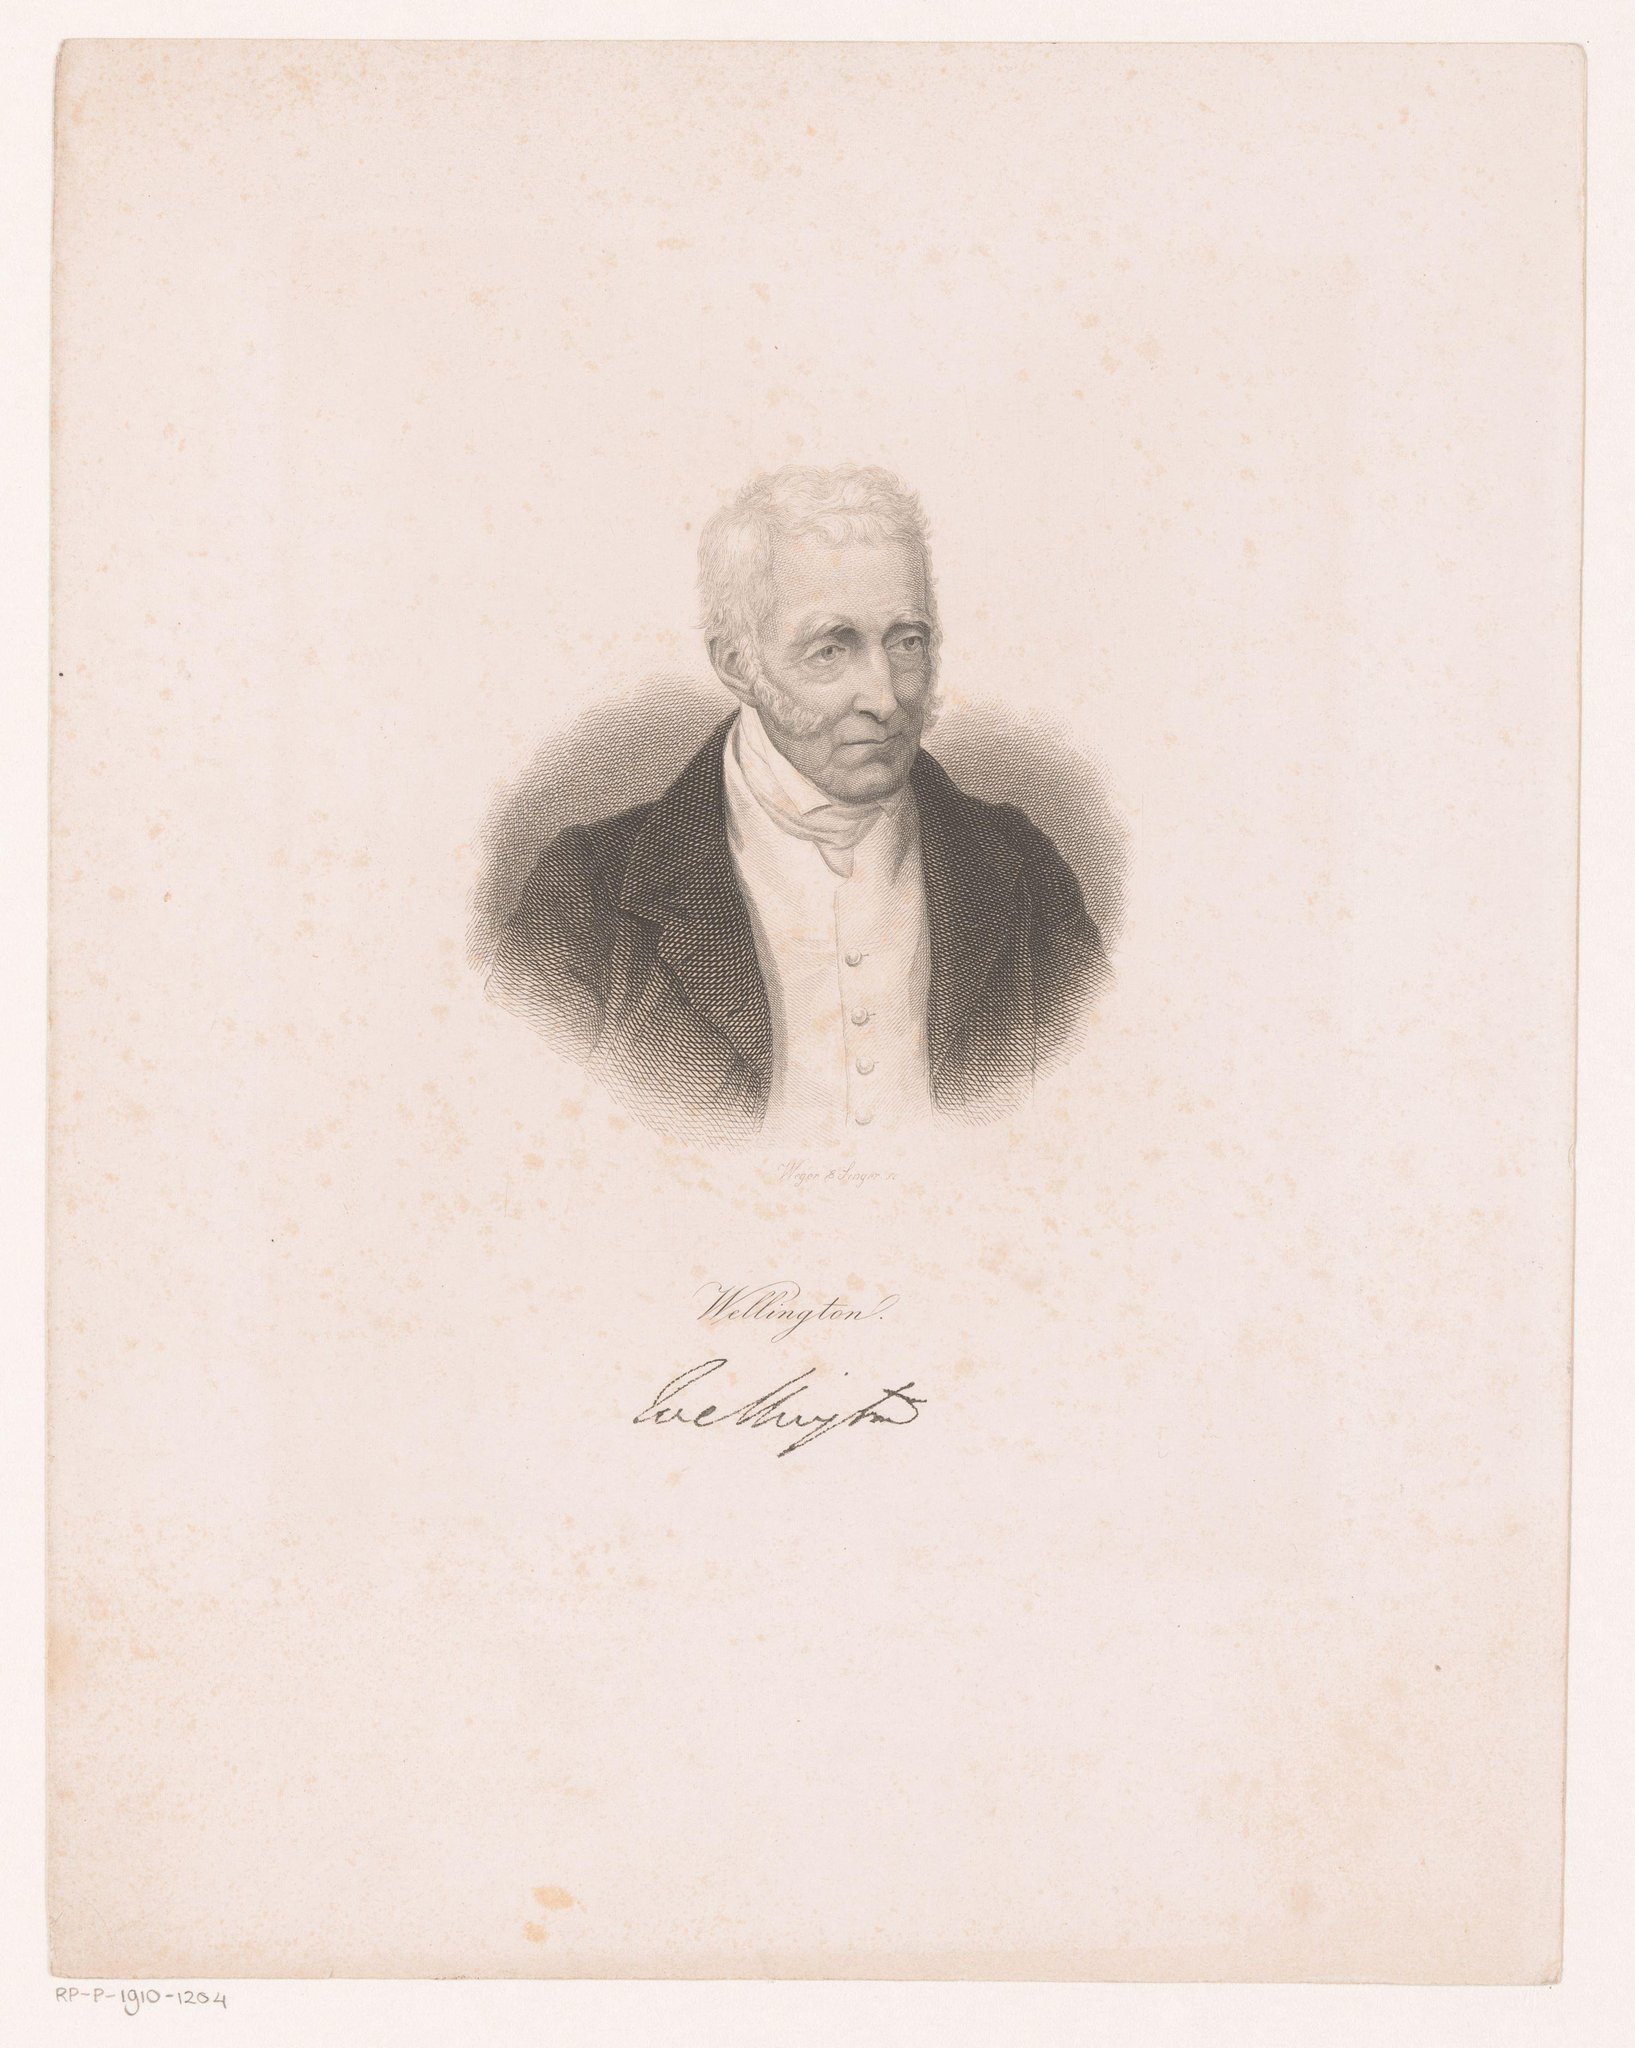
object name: print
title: Portret van Arthur Wellesley of Wellington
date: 1833-1892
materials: paper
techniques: engraving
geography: leipzig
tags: walmer castle, arthur wellesley of wellington, historical persons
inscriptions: collector's mark: Lugt 2228